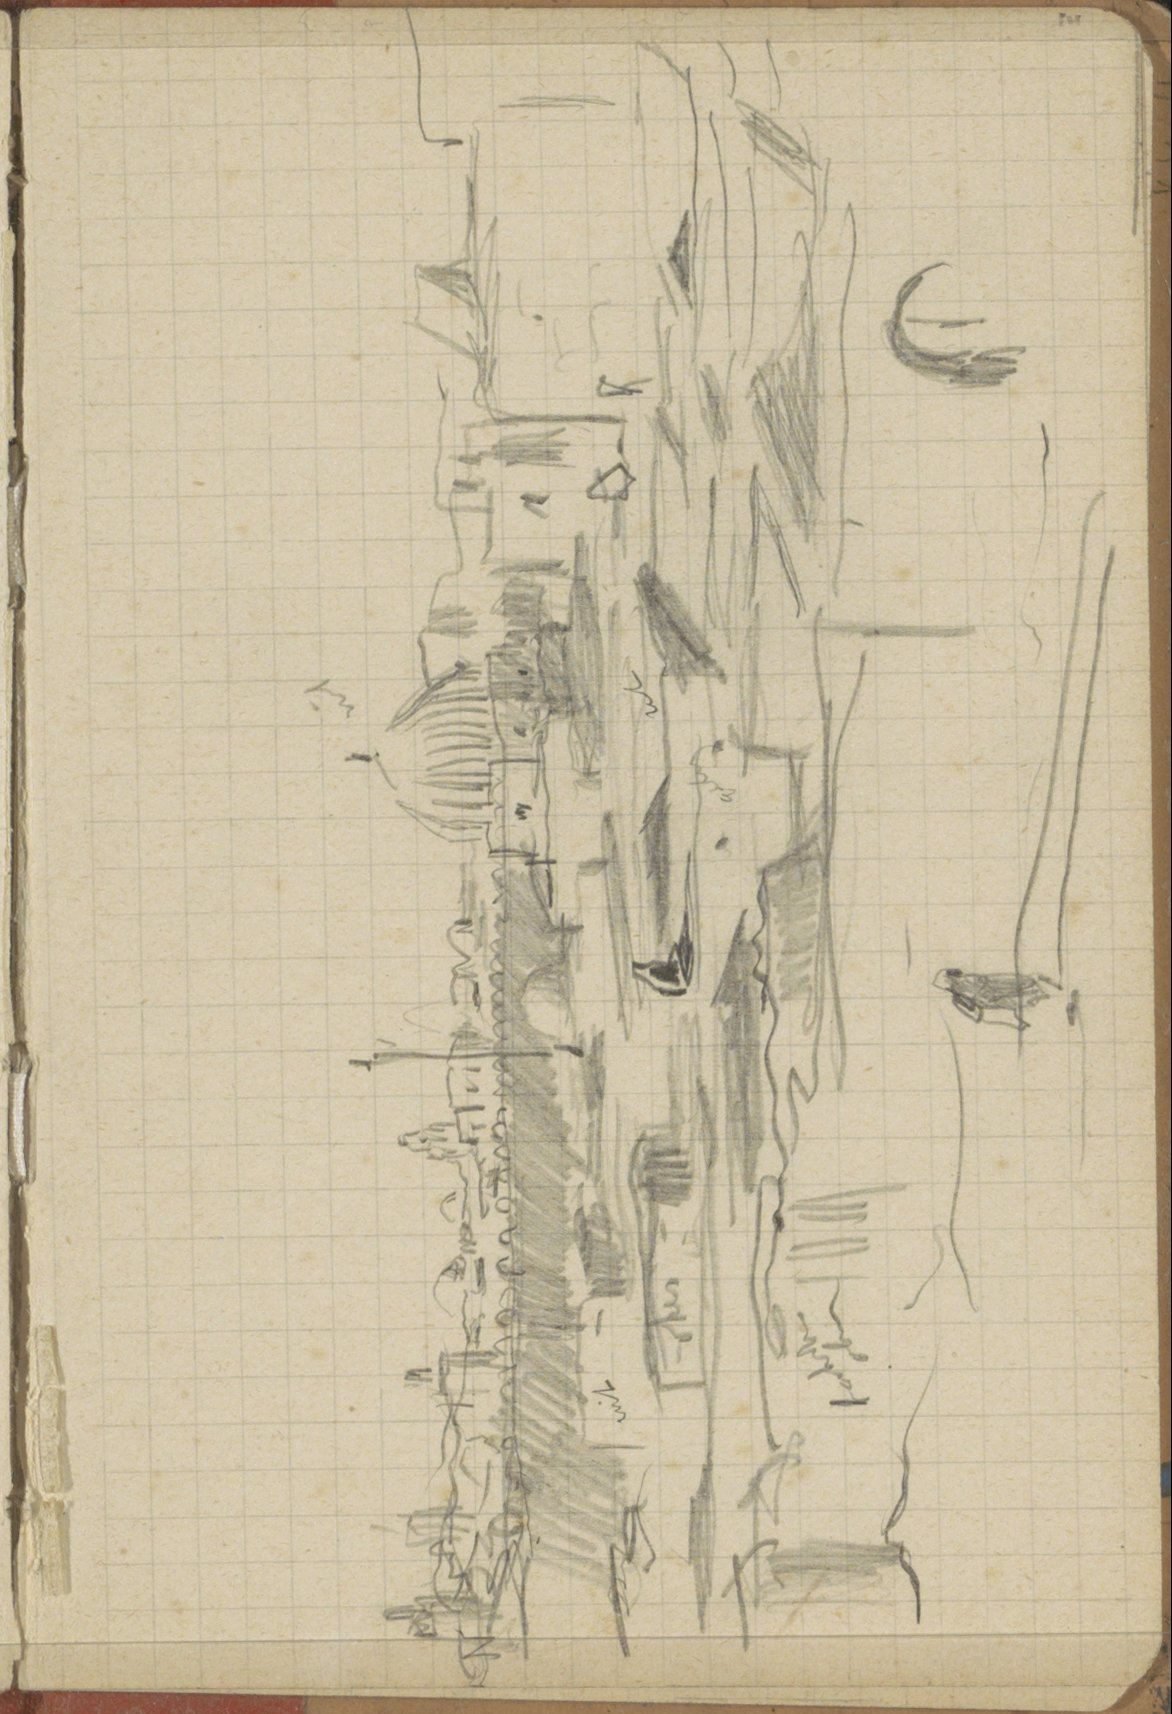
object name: sketchbook leaf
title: Stadsgezicht, mogelijk Kairouan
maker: marius bauer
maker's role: draughtsman, print maker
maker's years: 1867-1932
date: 1909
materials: pencil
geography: tunisia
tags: city-view, and landscape with man-made constructions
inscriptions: kleurnotitie, handgeschreven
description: Pagina 111 uit een schetsboek met 67 bladen.